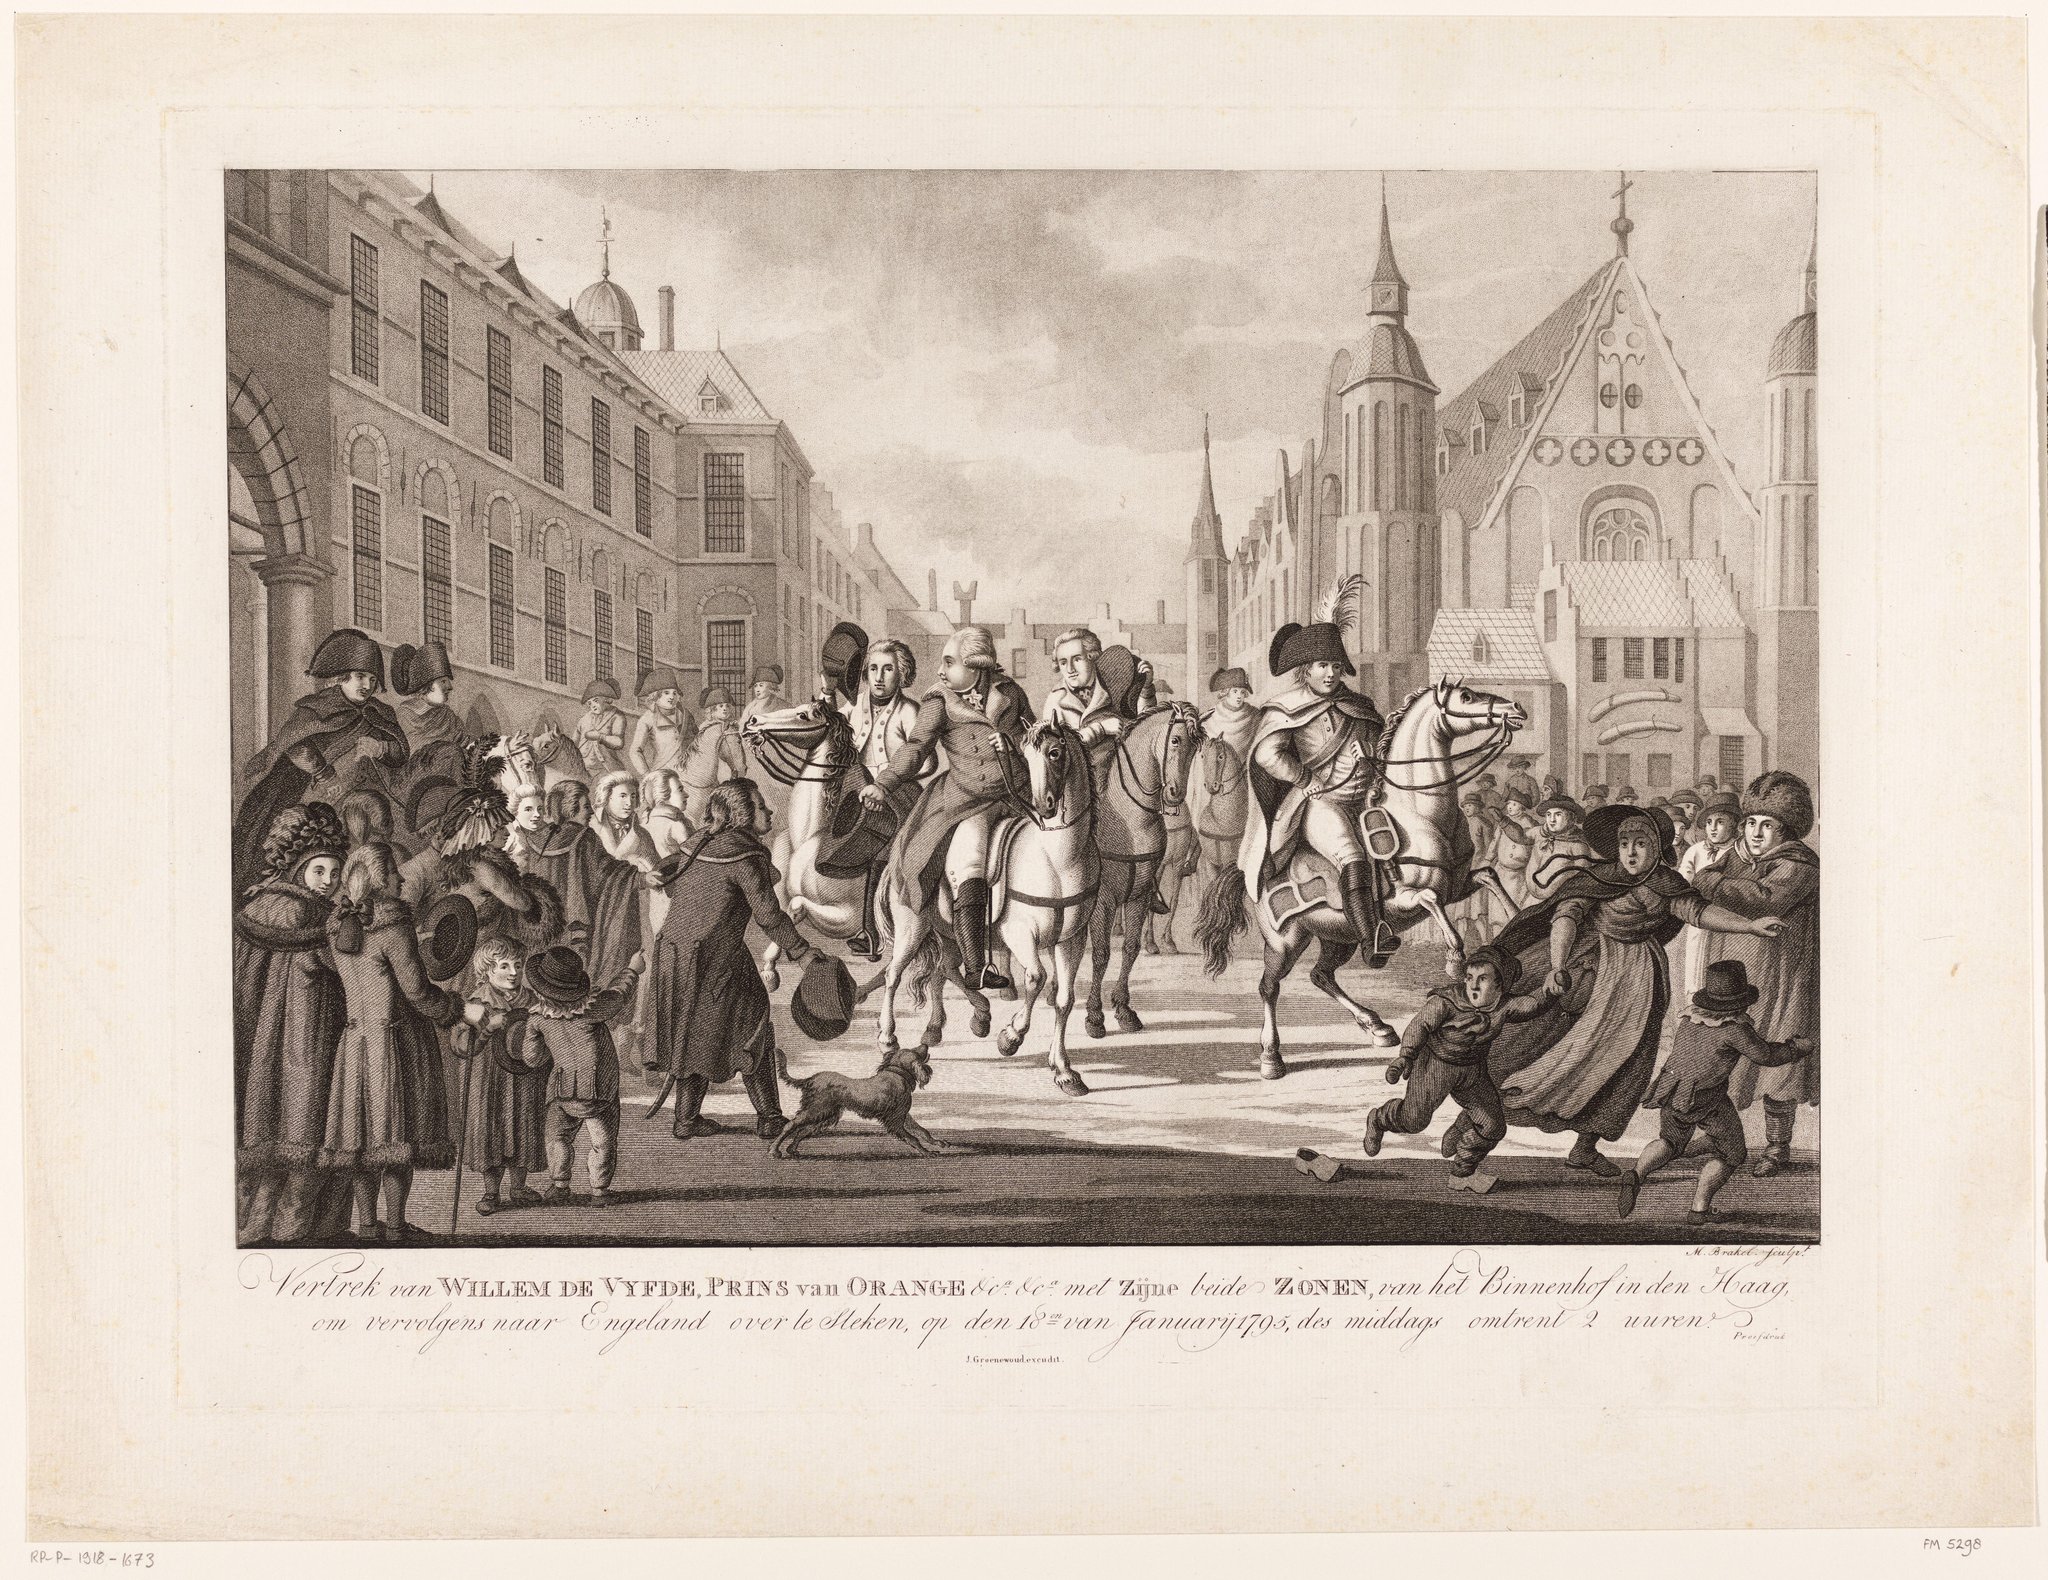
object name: print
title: Vertrek van Willem de Vyfde (...) met zijne beide zonen, van het Binnenhof in den Haag om vervolgens naar Engeland over te steken (...)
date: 1795-1797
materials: paper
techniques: etching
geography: rotterdam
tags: william v (prince of orange), berlin, william i of the netherlands, the hague, willem george frederik (prins van oranje-nassau)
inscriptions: collector's mark: Lugt 2233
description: De binnenplaats van het Binnenhof te Den Haag met een groep ruiters, waaronder Willem V en zijn twee zonen. Ze nemen afscheid van het volk voordat ze via Scheveningen met de boot naar Engeland vertrekken om te vluchten voor de Franse troepen.